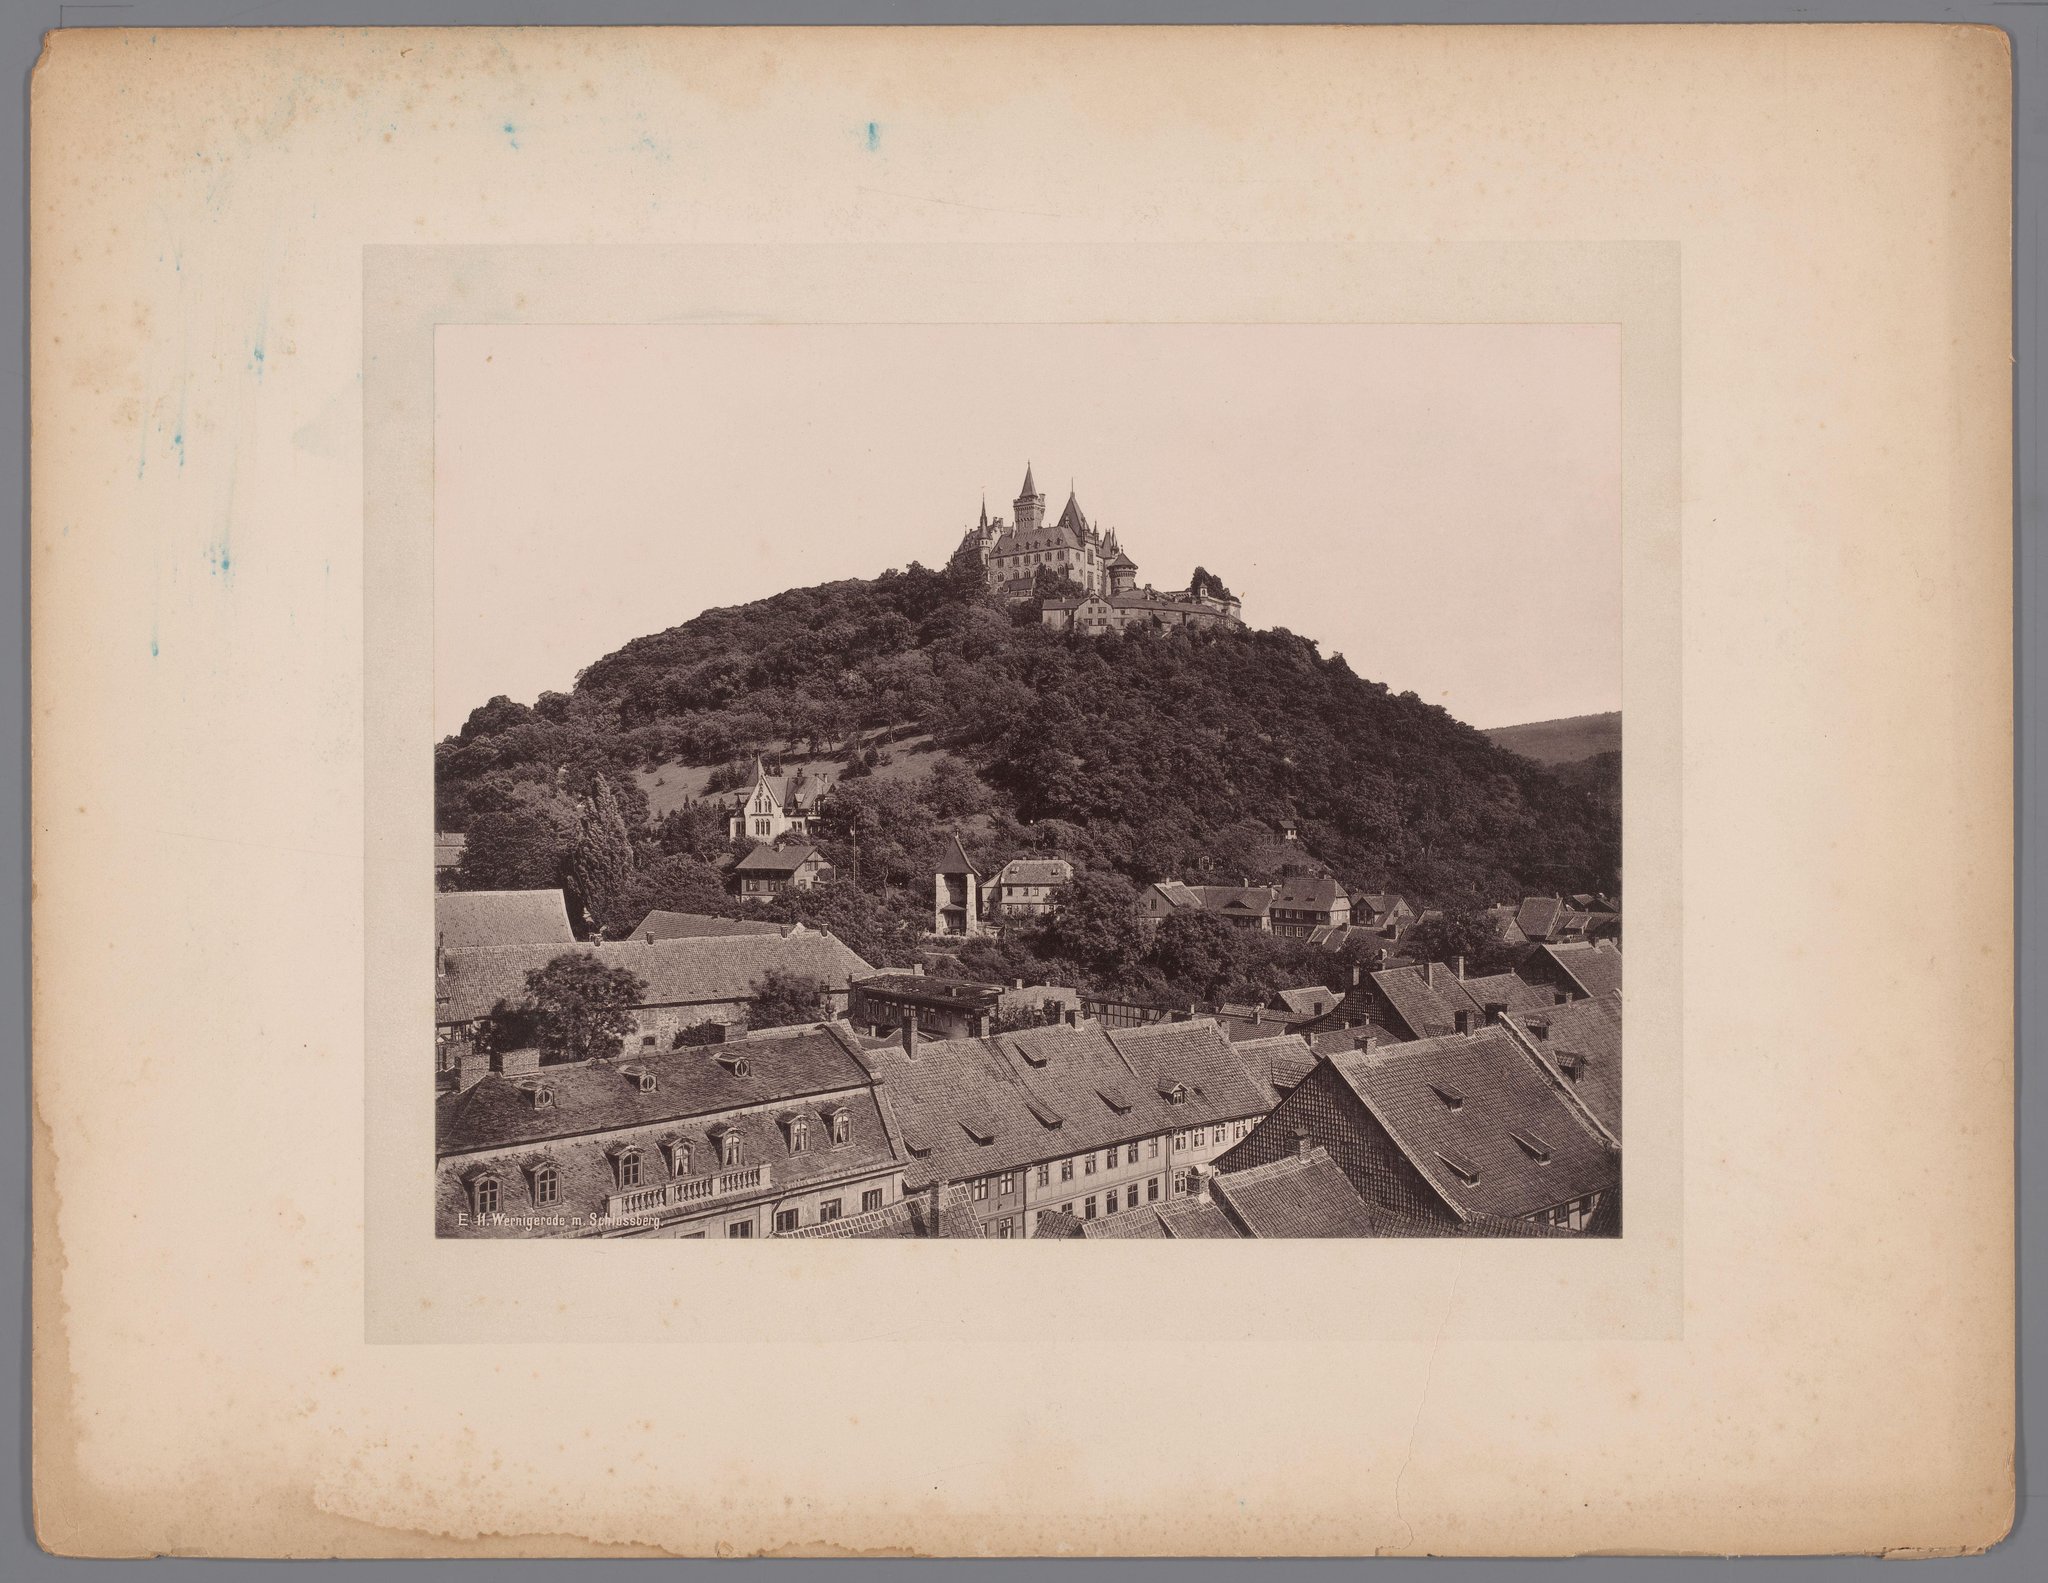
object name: photograph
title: "Wernigerode mit Schlossberg", deelstaat Sachsen-Anhalt, Duitsland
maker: Anonymous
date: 1885-1910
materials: cardboard, paper, photographic support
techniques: albumen print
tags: wernigerode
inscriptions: inscription: ‘E 11. Wernigerode m. Schlossberg.’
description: Gezicht op een slot op een beboste berg gelegen, met op de voorgrond de daken van de huizen van Wernigerode.